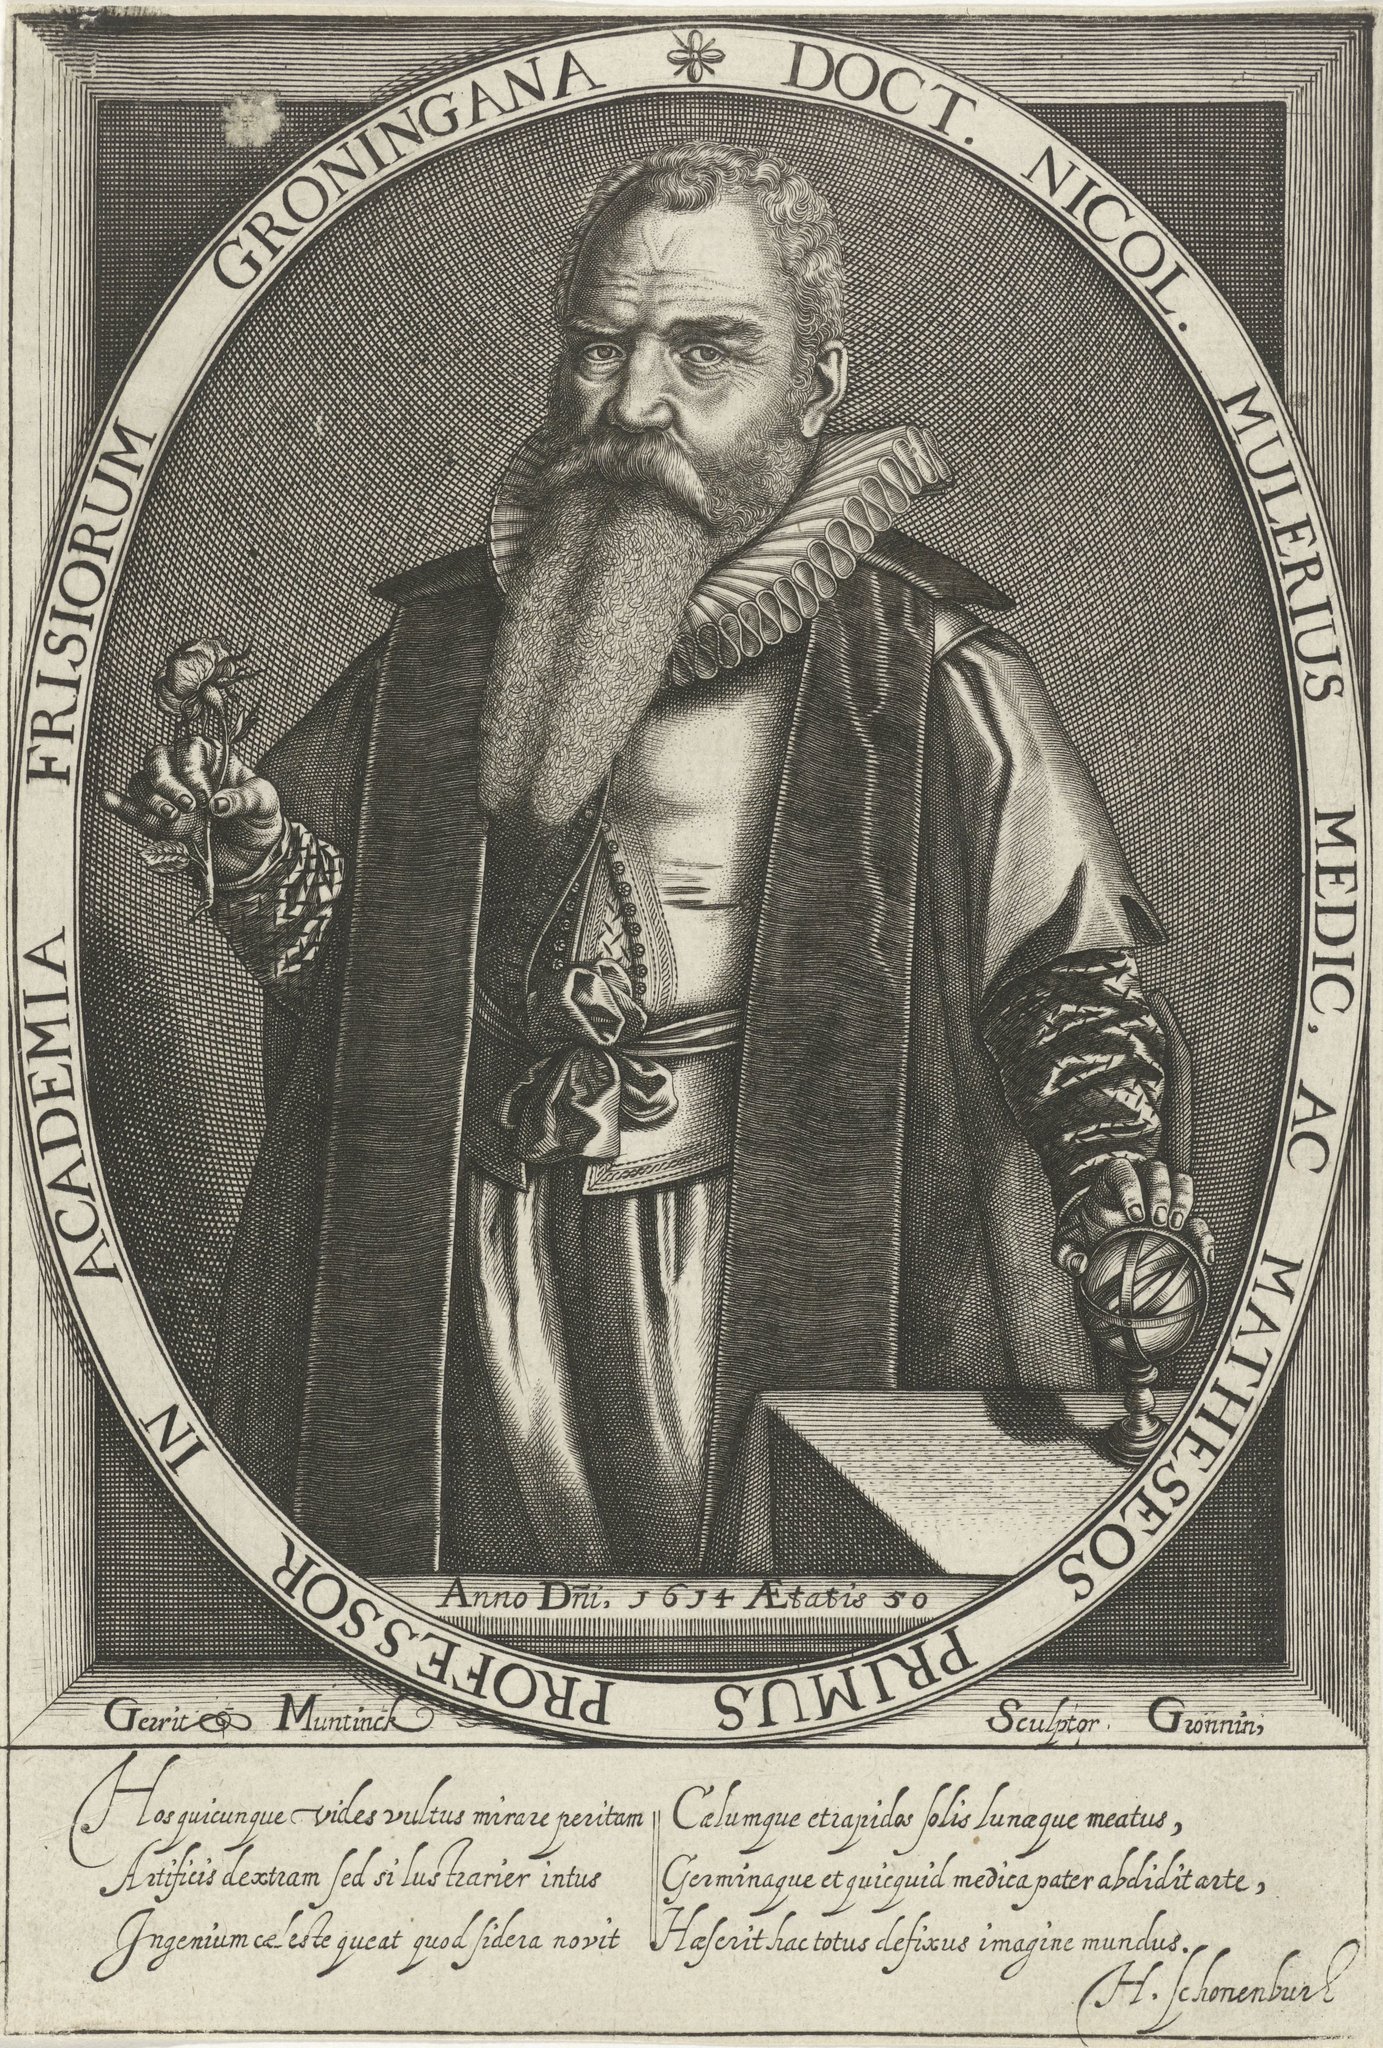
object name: print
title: Portret van Nicolaas Mulerius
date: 1614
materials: paper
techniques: engraving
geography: groningen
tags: flowers, armillary sphere, skeleton celestial globe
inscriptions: collector's mark: Lugt 2228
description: Portret van Nicolaas Mulerius, dokter en wiskundige te Groningen, op 50-jarige leeftijd. In zijn ene hand houdt hij een bloem en de andere hand rust op een armillarium. Onderaan in de marge een zesregelige tekst in het Latijn.